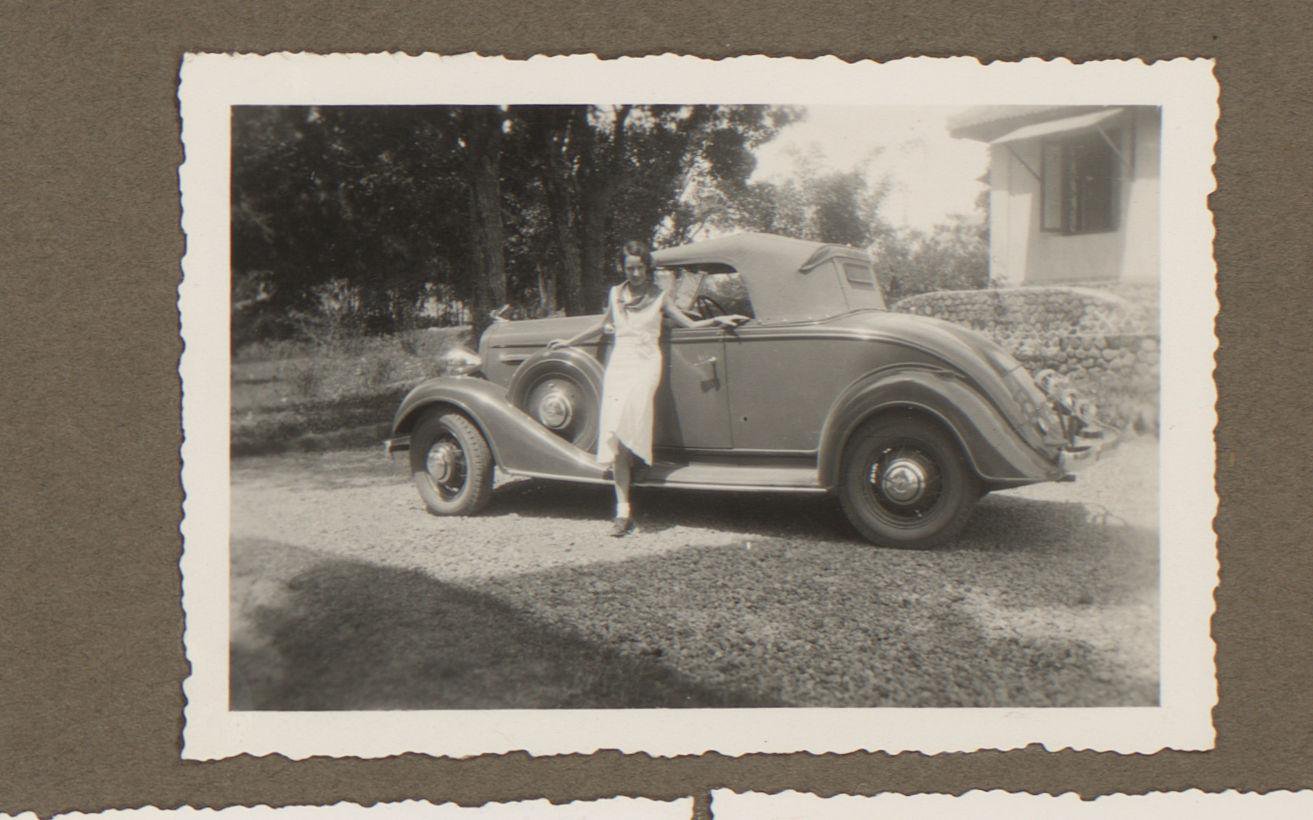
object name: photograph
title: Ada Krüseman bij een auto, Boyolali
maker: Anonymous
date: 1932-1936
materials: paper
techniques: gelatin silver print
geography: boyolali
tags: automobile